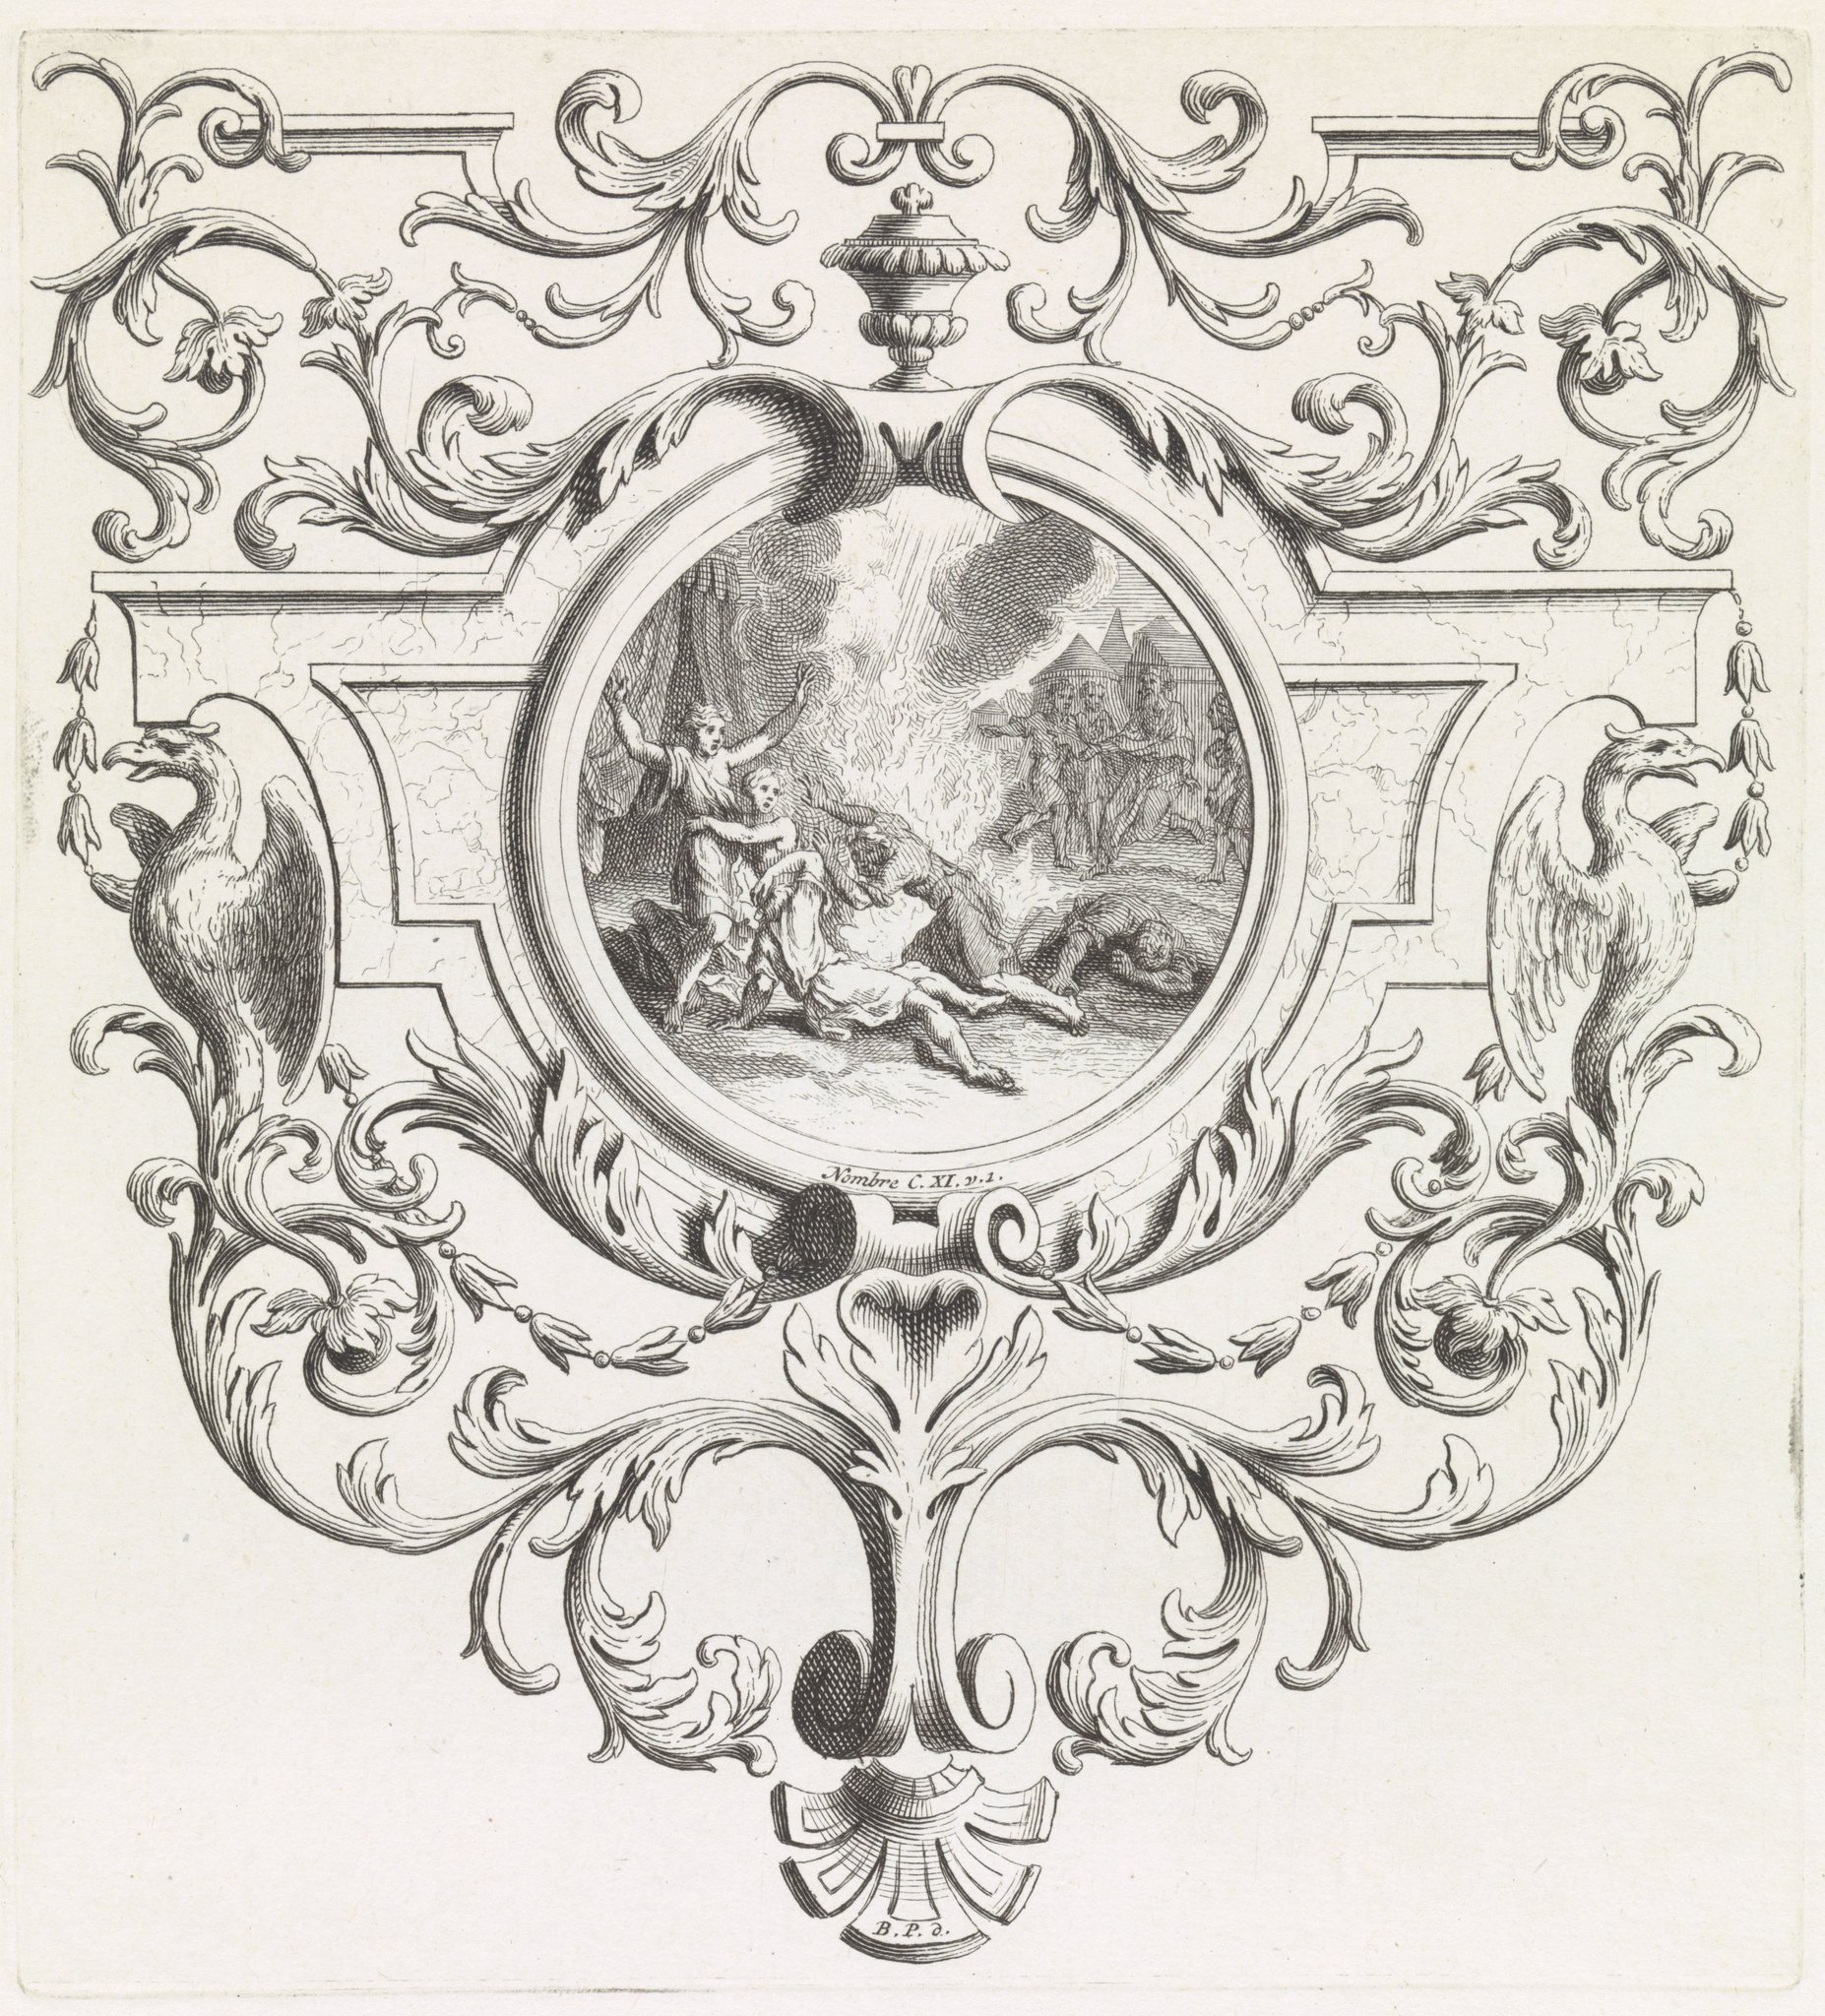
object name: ornament print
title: Vuur van God doodt mensen en Ornament met wapentuig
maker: bernard picart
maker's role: draughtsman, print maker, publisher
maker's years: 1673-1733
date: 1683-1733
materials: paper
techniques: engraving, etching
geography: amsterdam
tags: helmet, ornament derived from animal forms, at taberah the people are punished by fire which consumes one end of the camp, scrollwork, strapwork ~ ornament, foliage, tendrils, branches ~ ornament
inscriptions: collector's mark: Lugt 2233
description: Prenten oorspronkelijk bedoeld voor: Figures de la Bible. Amsterdam, Bernard Picart, 1720. Prenten tevens oorspronkelijk bedoeld voor: Taferelen der voornaamste geschiedenissen van het Oude en Nieuwe Testament (...) door de vermaarde kunstenaars Hoet, Houbraken, en Picart getekent (...) en met beschrijvingen uitgebreid. Den Haag: Pieter de Hondt, 1728. Prenten kunnen mogelijk ook zijn gebruikt in andere bijbels.